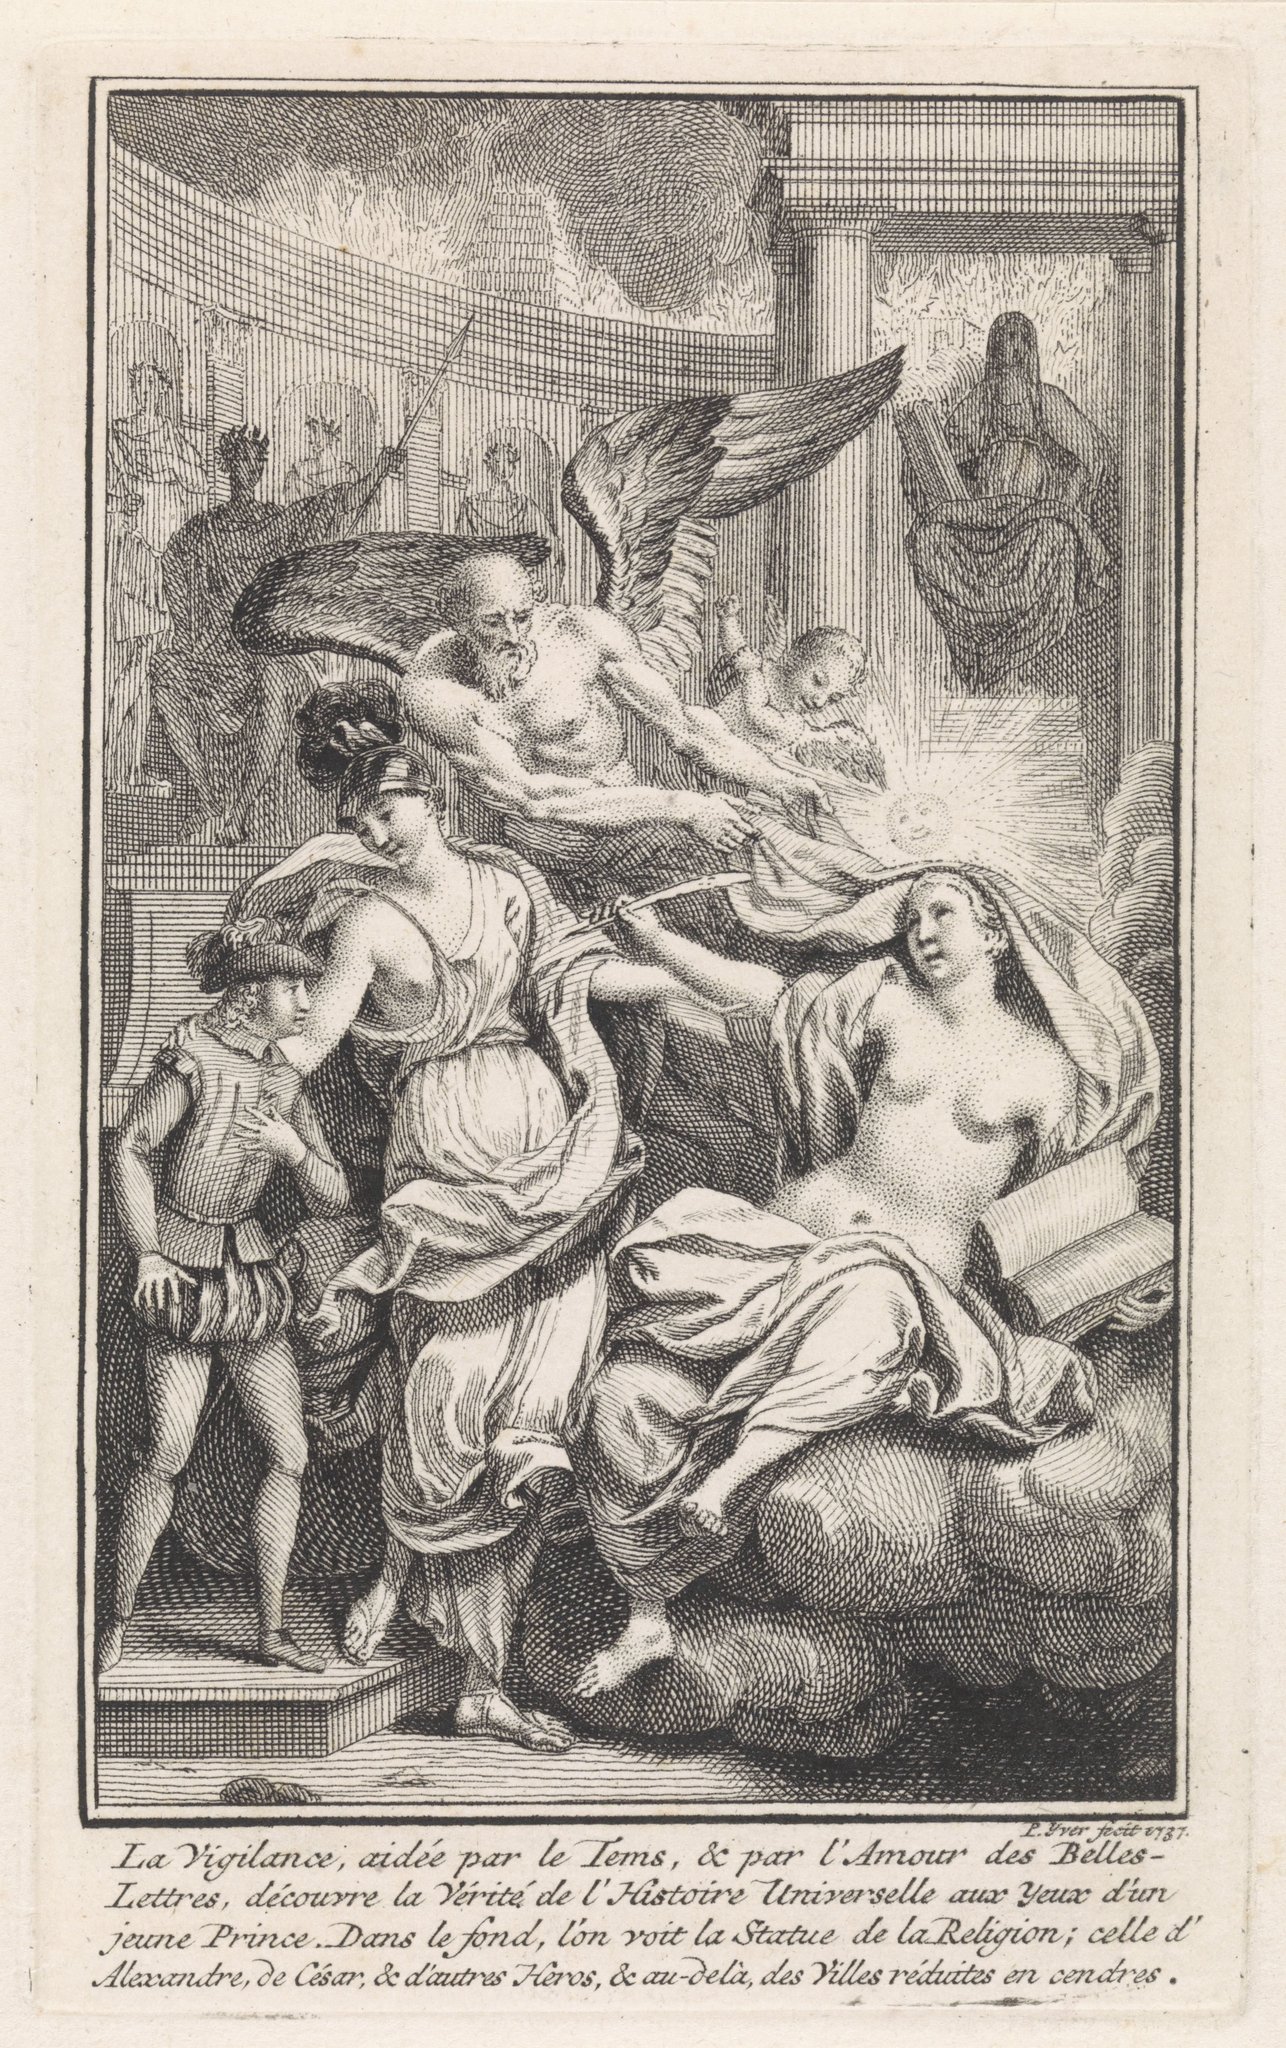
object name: print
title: De Waarheid van de universele geschiedenis onthuld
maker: pieter yver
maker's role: print maker, publisher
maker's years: 1712-1787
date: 1737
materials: paper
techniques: engraving, etching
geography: amsterdam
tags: time revealing truth; time carrying truth aloft, alertness, vigilance; 'guardia', 'vigilanza', 'vigilanza per difendersi & oppugnare altri' (ripa), crown prince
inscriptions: collector's mark: Lugt 240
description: Waakzaamheid, met een helm op het hoofd, Vader Tijd, en Amor onthullen de Waarheid van de universele geschiedenis voor de ogen van een jonge prins. Op de achtergrond een standbeeld voor religie en standbeelden van de helden uit het verleden, onder andere Alexander en Cesar. Onderaan in de marge een vierregelige tekst in het Frans.